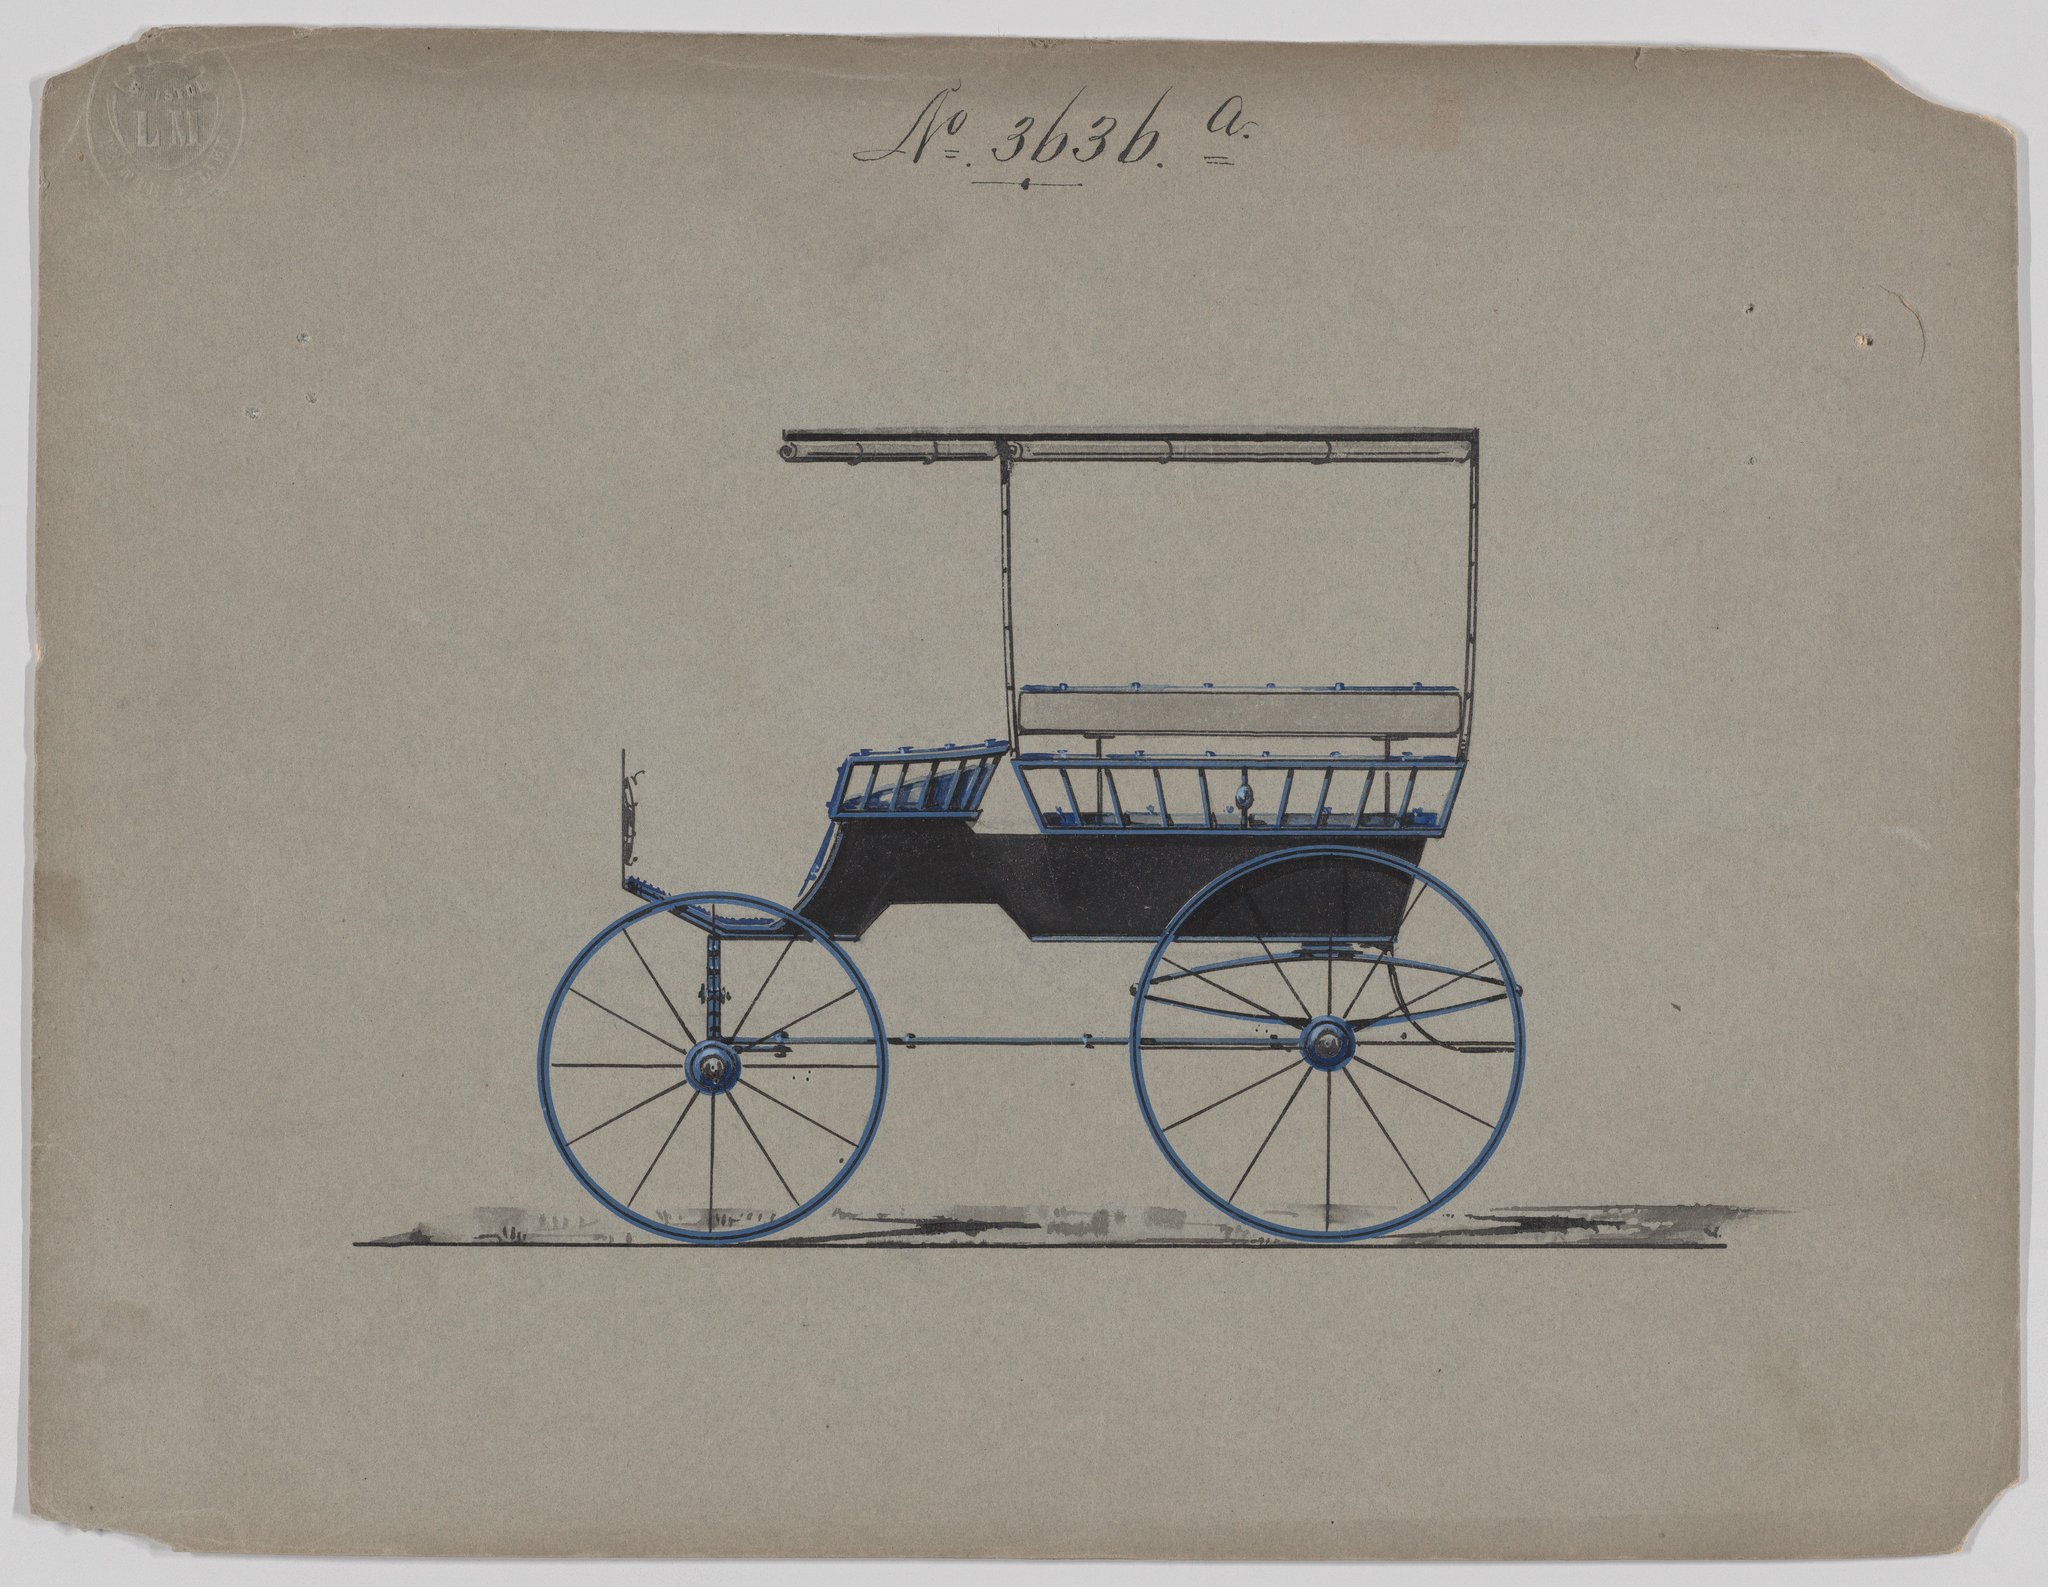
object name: drawing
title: Design for Omnibus or Wagonette, no. 3636a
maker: brewster & co.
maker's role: manufacturer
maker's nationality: american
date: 1880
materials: gouache, gum arabic, ink, watercolor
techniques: pen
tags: carriages